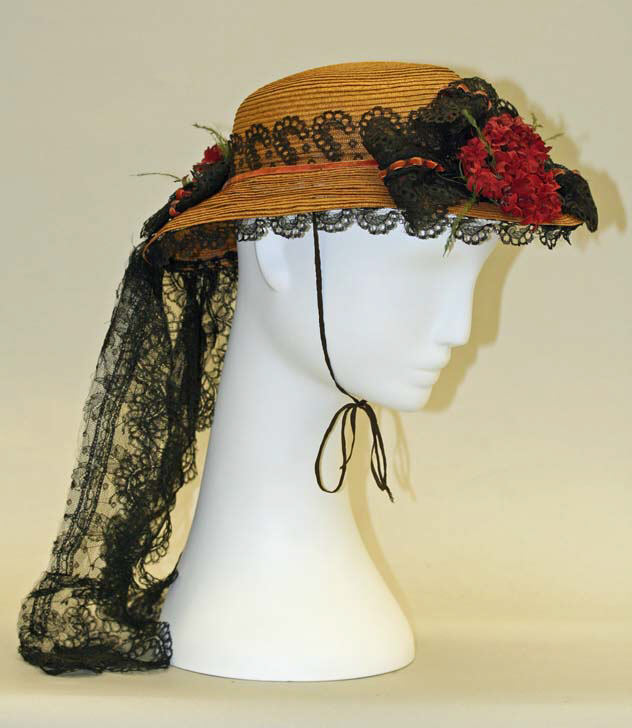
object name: hat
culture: french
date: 1863-1865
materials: fiber